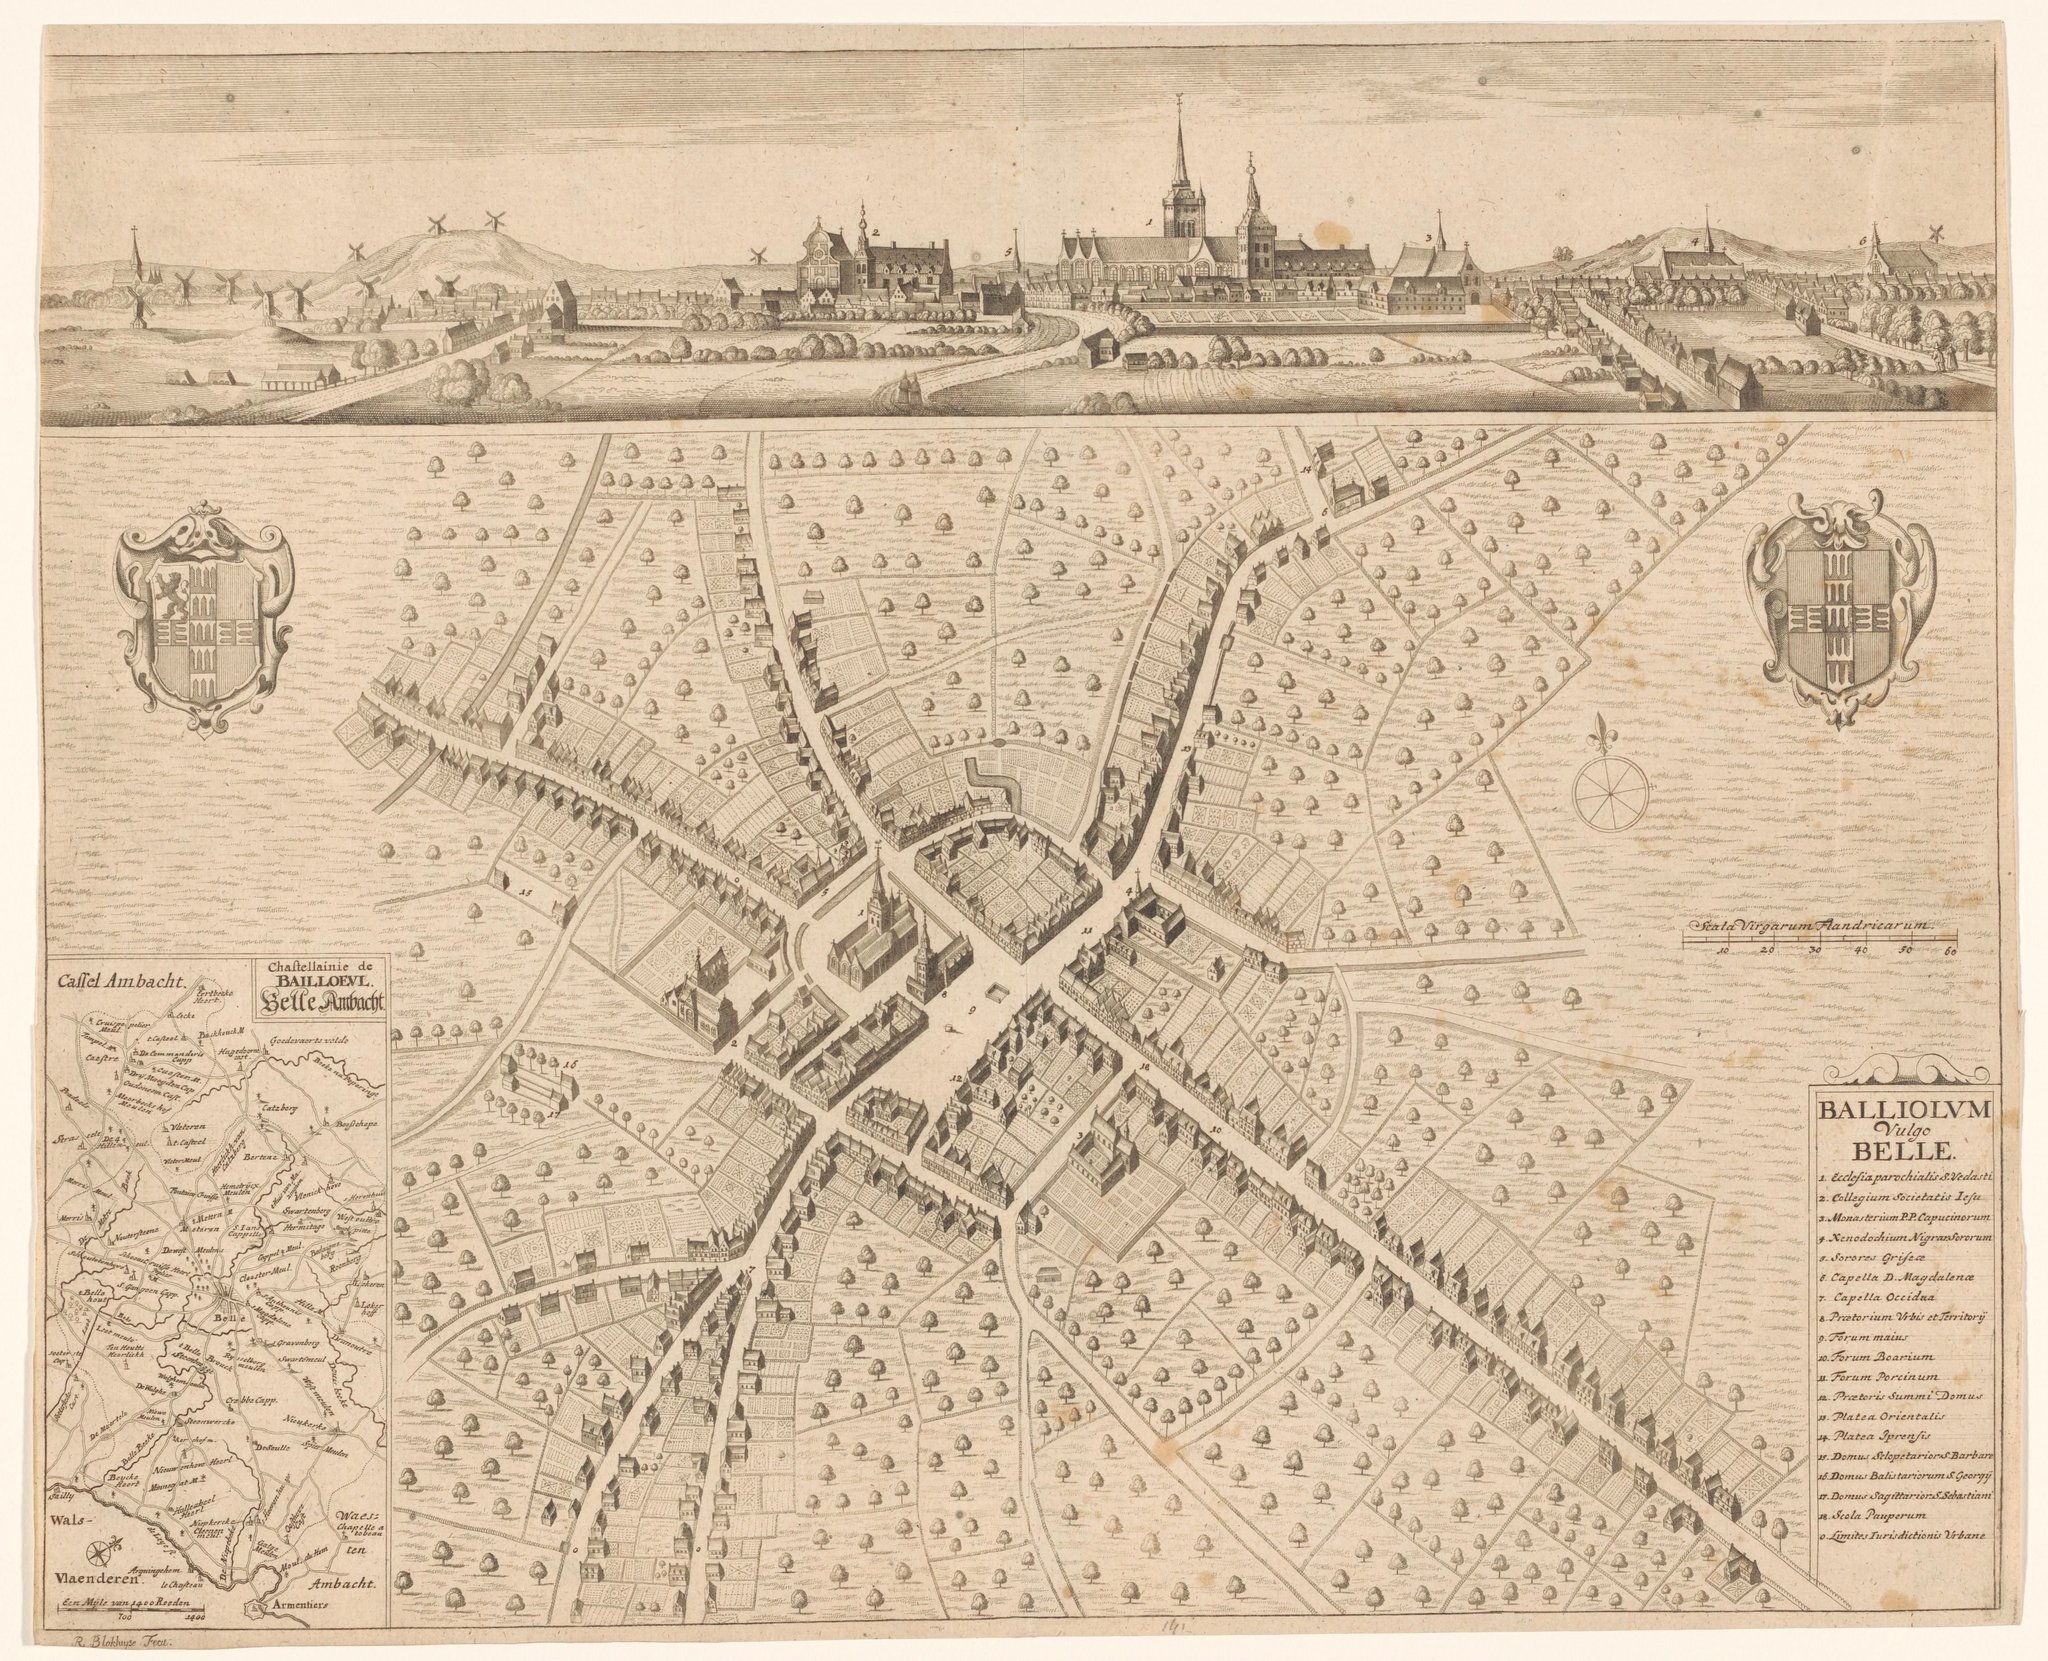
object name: area plan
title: Plattegrond van en gezicht op Belle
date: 1735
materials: paper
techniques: engraving, etching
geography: brussels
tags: coat of arms (as symbol of the state, etc.) (+ city; municipal), maps of separate countries or regions, maps of cities, coat of arms (as symbol of the state, etc.) (+ province; provincial), prospect of city, town panorama, silhouette of city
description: Boven een gezicht op Belle, in het Frans Bailleul genoemd. Onder een plattegrond van Belle in vogelvluchtperspectief. Linksonder een inzet met een kaart van de kasselrij Belle. Linksboven het wapen van de kasselrij Belle. Rechtsboven het wapen van Belle. Rechtsonder een kader met legenda 1-18 en O, met daarboven een schaalstok: Scala Virgarum Flandricarum.